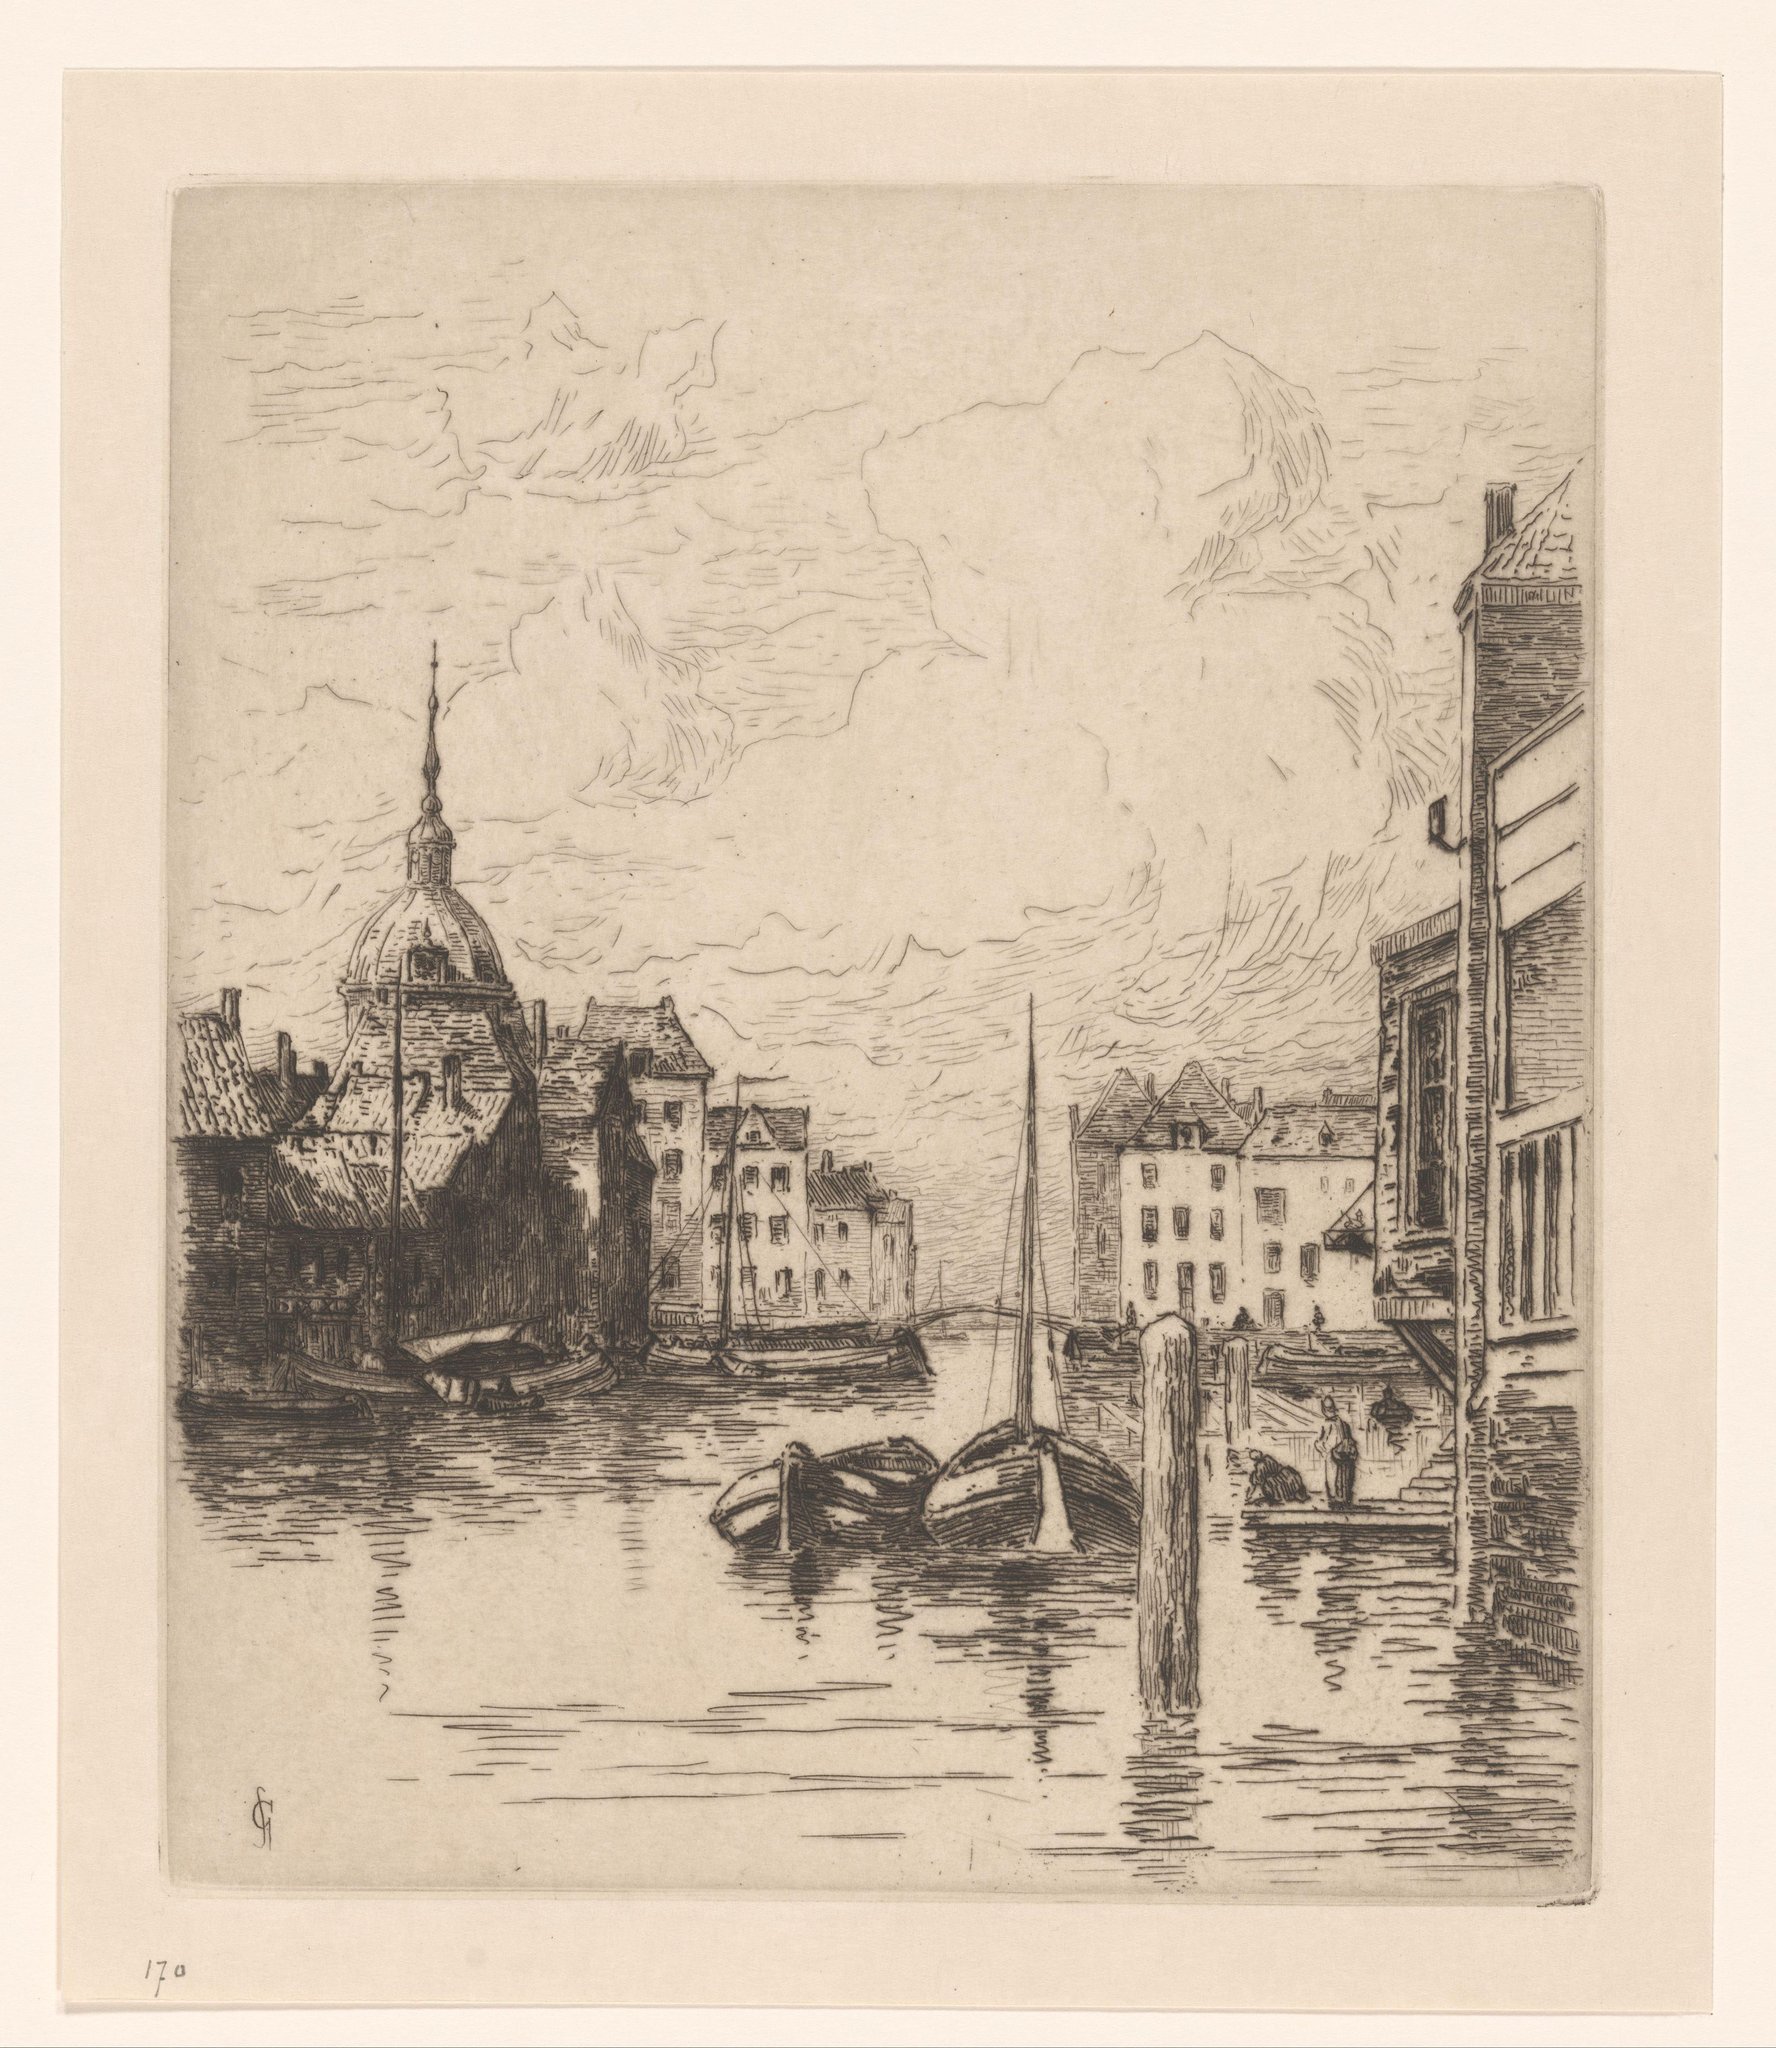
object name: print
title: Gezicht op de Wijnhaven te Dordrecht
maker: carel nicolaas storm van s-gravesande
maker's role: draughtsman, print maker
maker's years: 1841-1924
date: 1880-1886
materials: paper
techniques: drypoint, etching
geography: netherlands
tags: harbour, city-gate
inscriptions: collector's mark: Lugt 2228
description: Havengezicht met links de toren van de Groothoofdspoort.